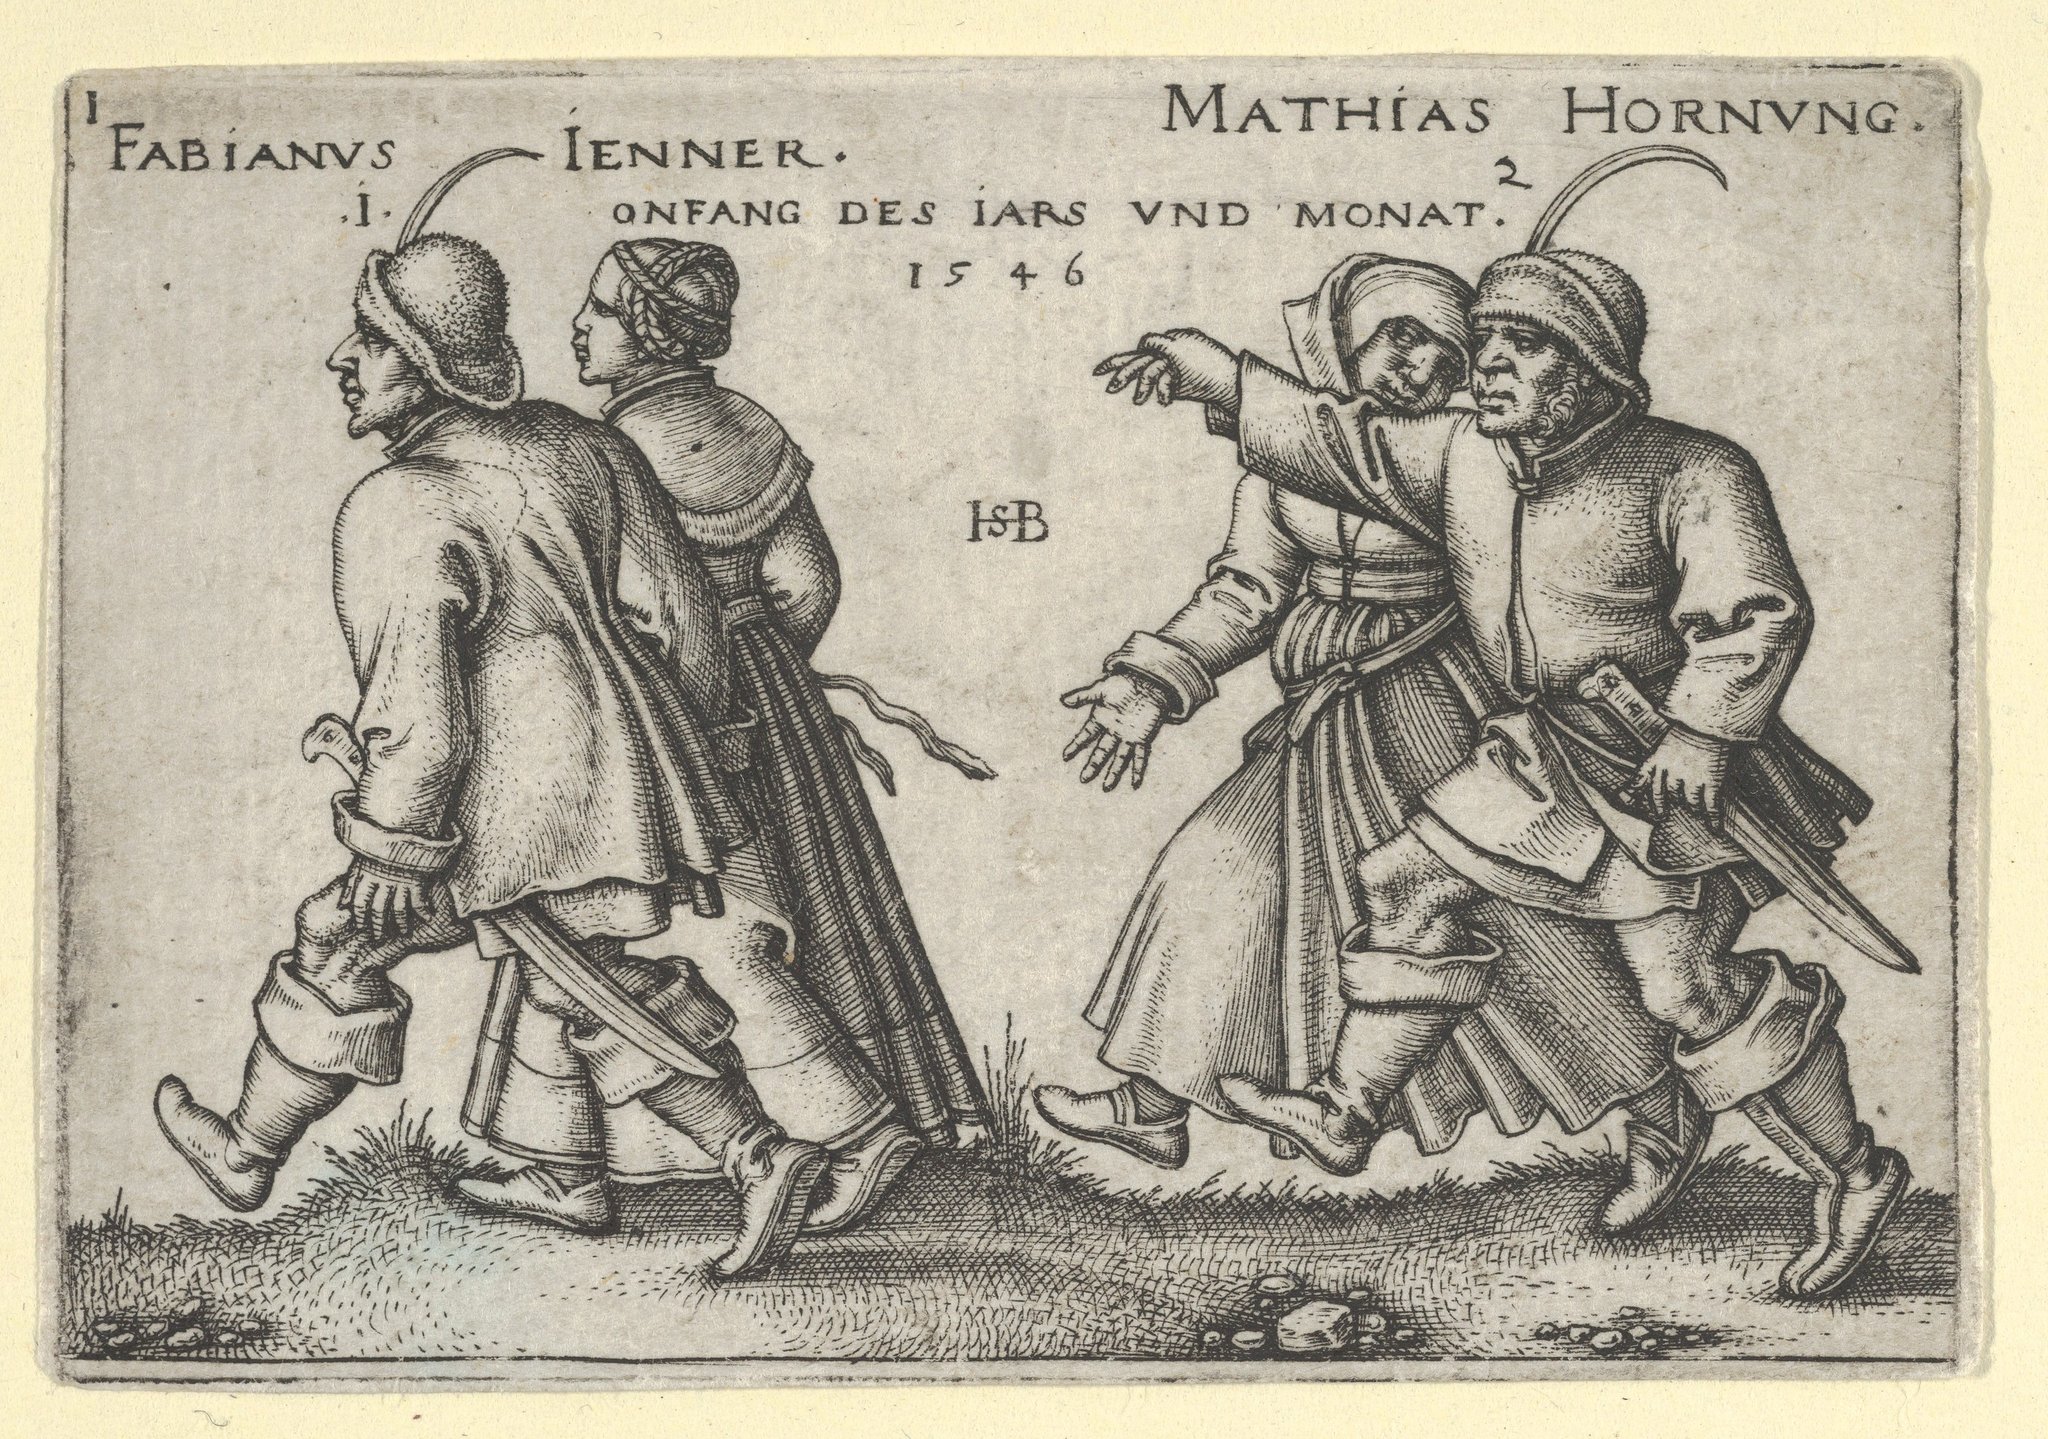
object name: print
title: January and February from "The Peasants' Feast" or "The Twelve Months"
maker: sebald beham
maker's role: artist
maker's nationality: german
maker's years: 1500-1550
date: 1546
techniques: engraving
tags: swords,men,women